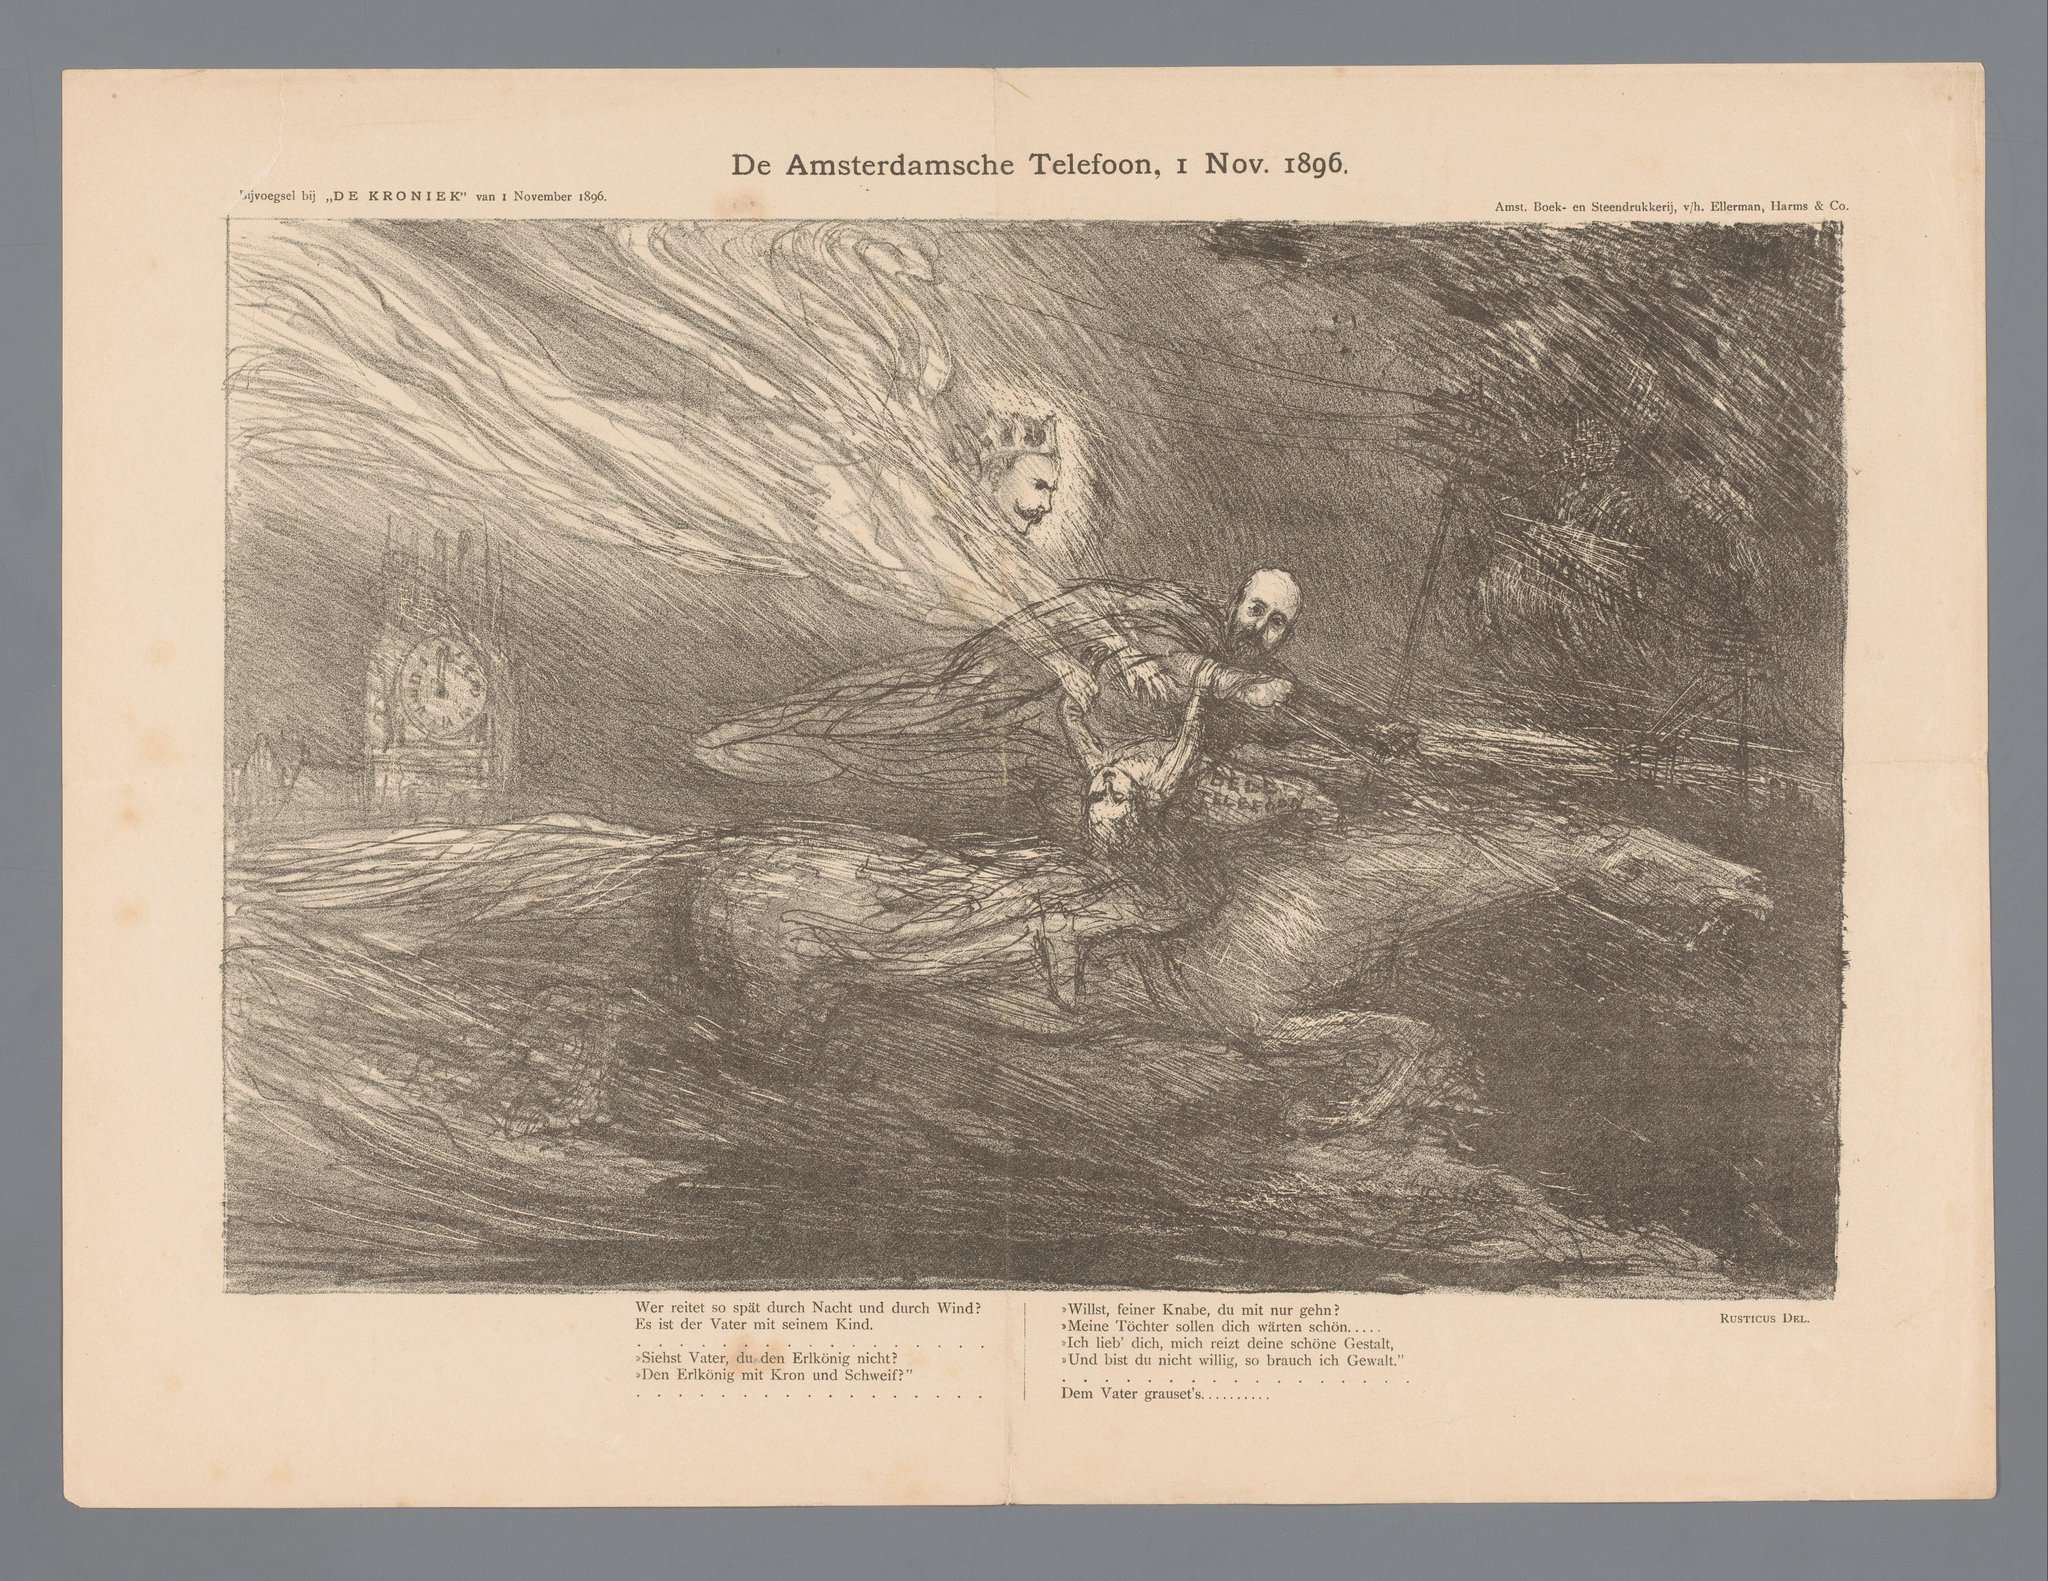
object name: cartoon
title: De Amsterdamsche Telefoon, 1 Nov. 1896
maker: marius bauer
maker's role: draughtsman, print maker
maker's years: 1867-1932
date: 1896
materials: paper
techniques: lithograph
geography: netherlands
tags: voorschoten, the hague, politician, telephone, municipal government, political caricatures and satires, amsterdam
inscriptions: date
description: Spotprent op de pogingen van Hubrecht, de directeur van de Bell Telephoon Maatschappij, om te verhinderen dat Treub en de gemeente Amsterdam het telefoonnet voor 1 november 1896 klaar heeft. Strijd wordt verbeeld door middel van het verhaal van de Erlkönig van Goethe. Verschenen in de bijvoegsel van 'De Kroniek' van 1 november 1896.